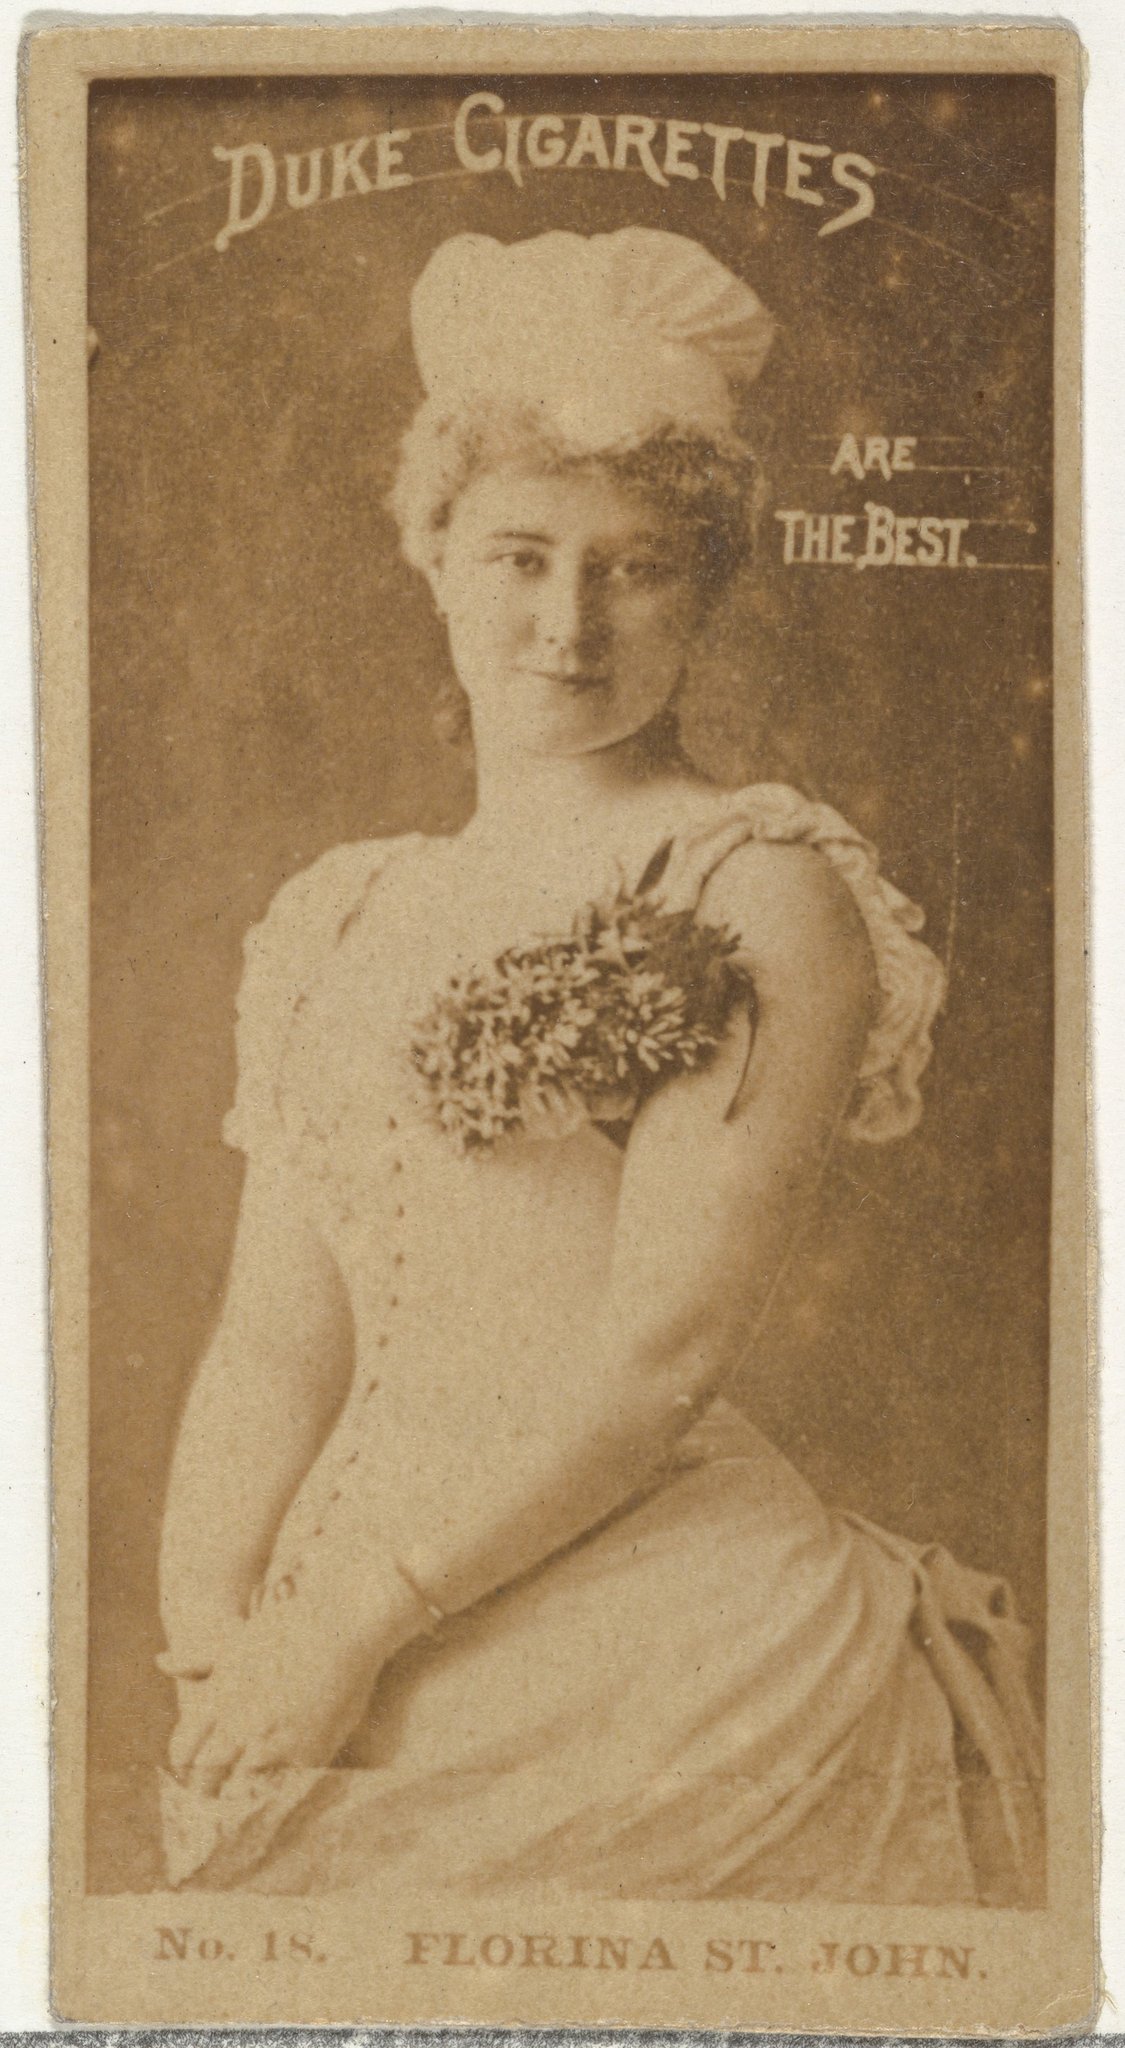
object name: photograph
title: Card Number 18, Florina St. John, from the Actors and Actresses series (N145-6) issued by Duke Sons & Co. to promote Duke Cigarettes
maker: w. duke, sons & co.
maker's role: publisher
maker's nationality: american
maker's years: 1870-1920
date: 1880-1889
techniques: albumen silver print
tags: portraits,women,actresses